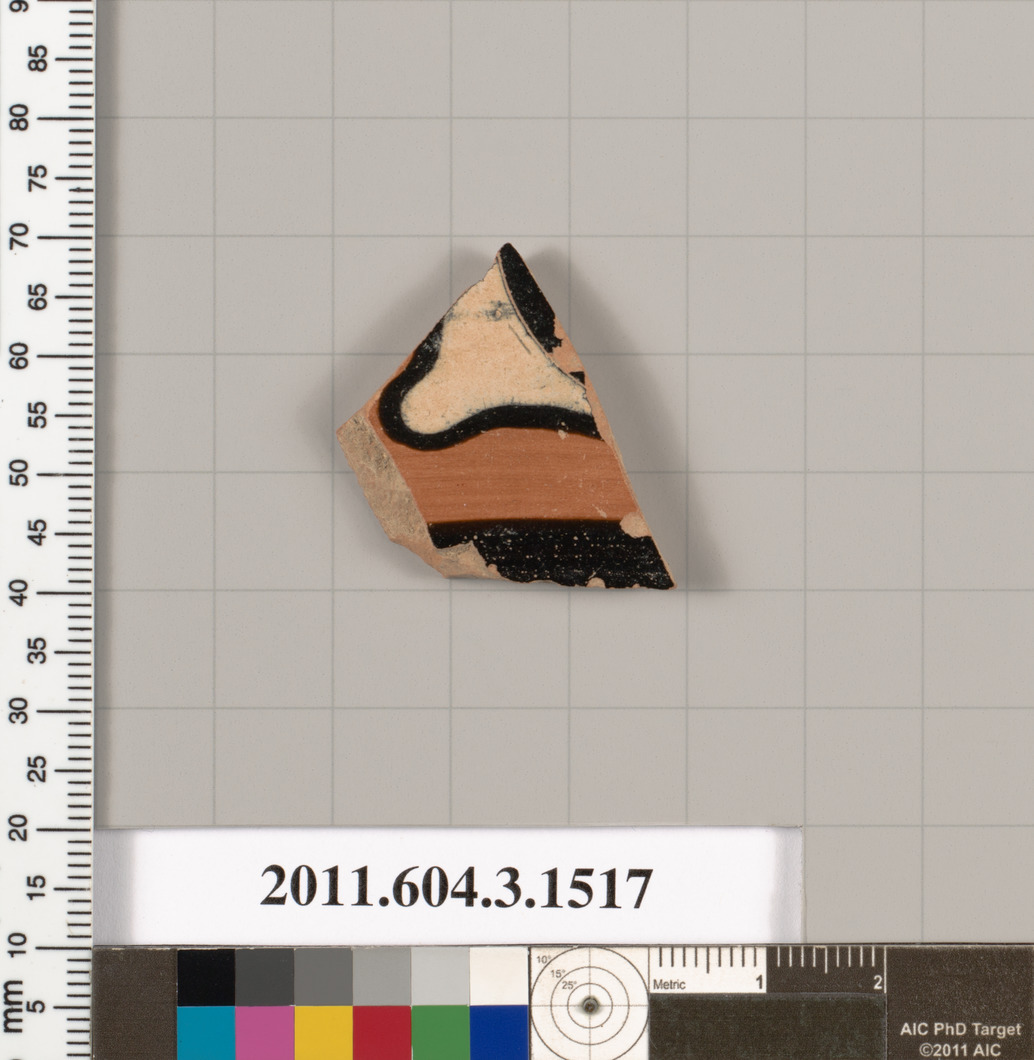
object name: skyphos fragment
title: Terracotta fragment of a skyphos (deep drinking cup)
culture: greek, attic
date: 520-510 BCE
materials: terracotta